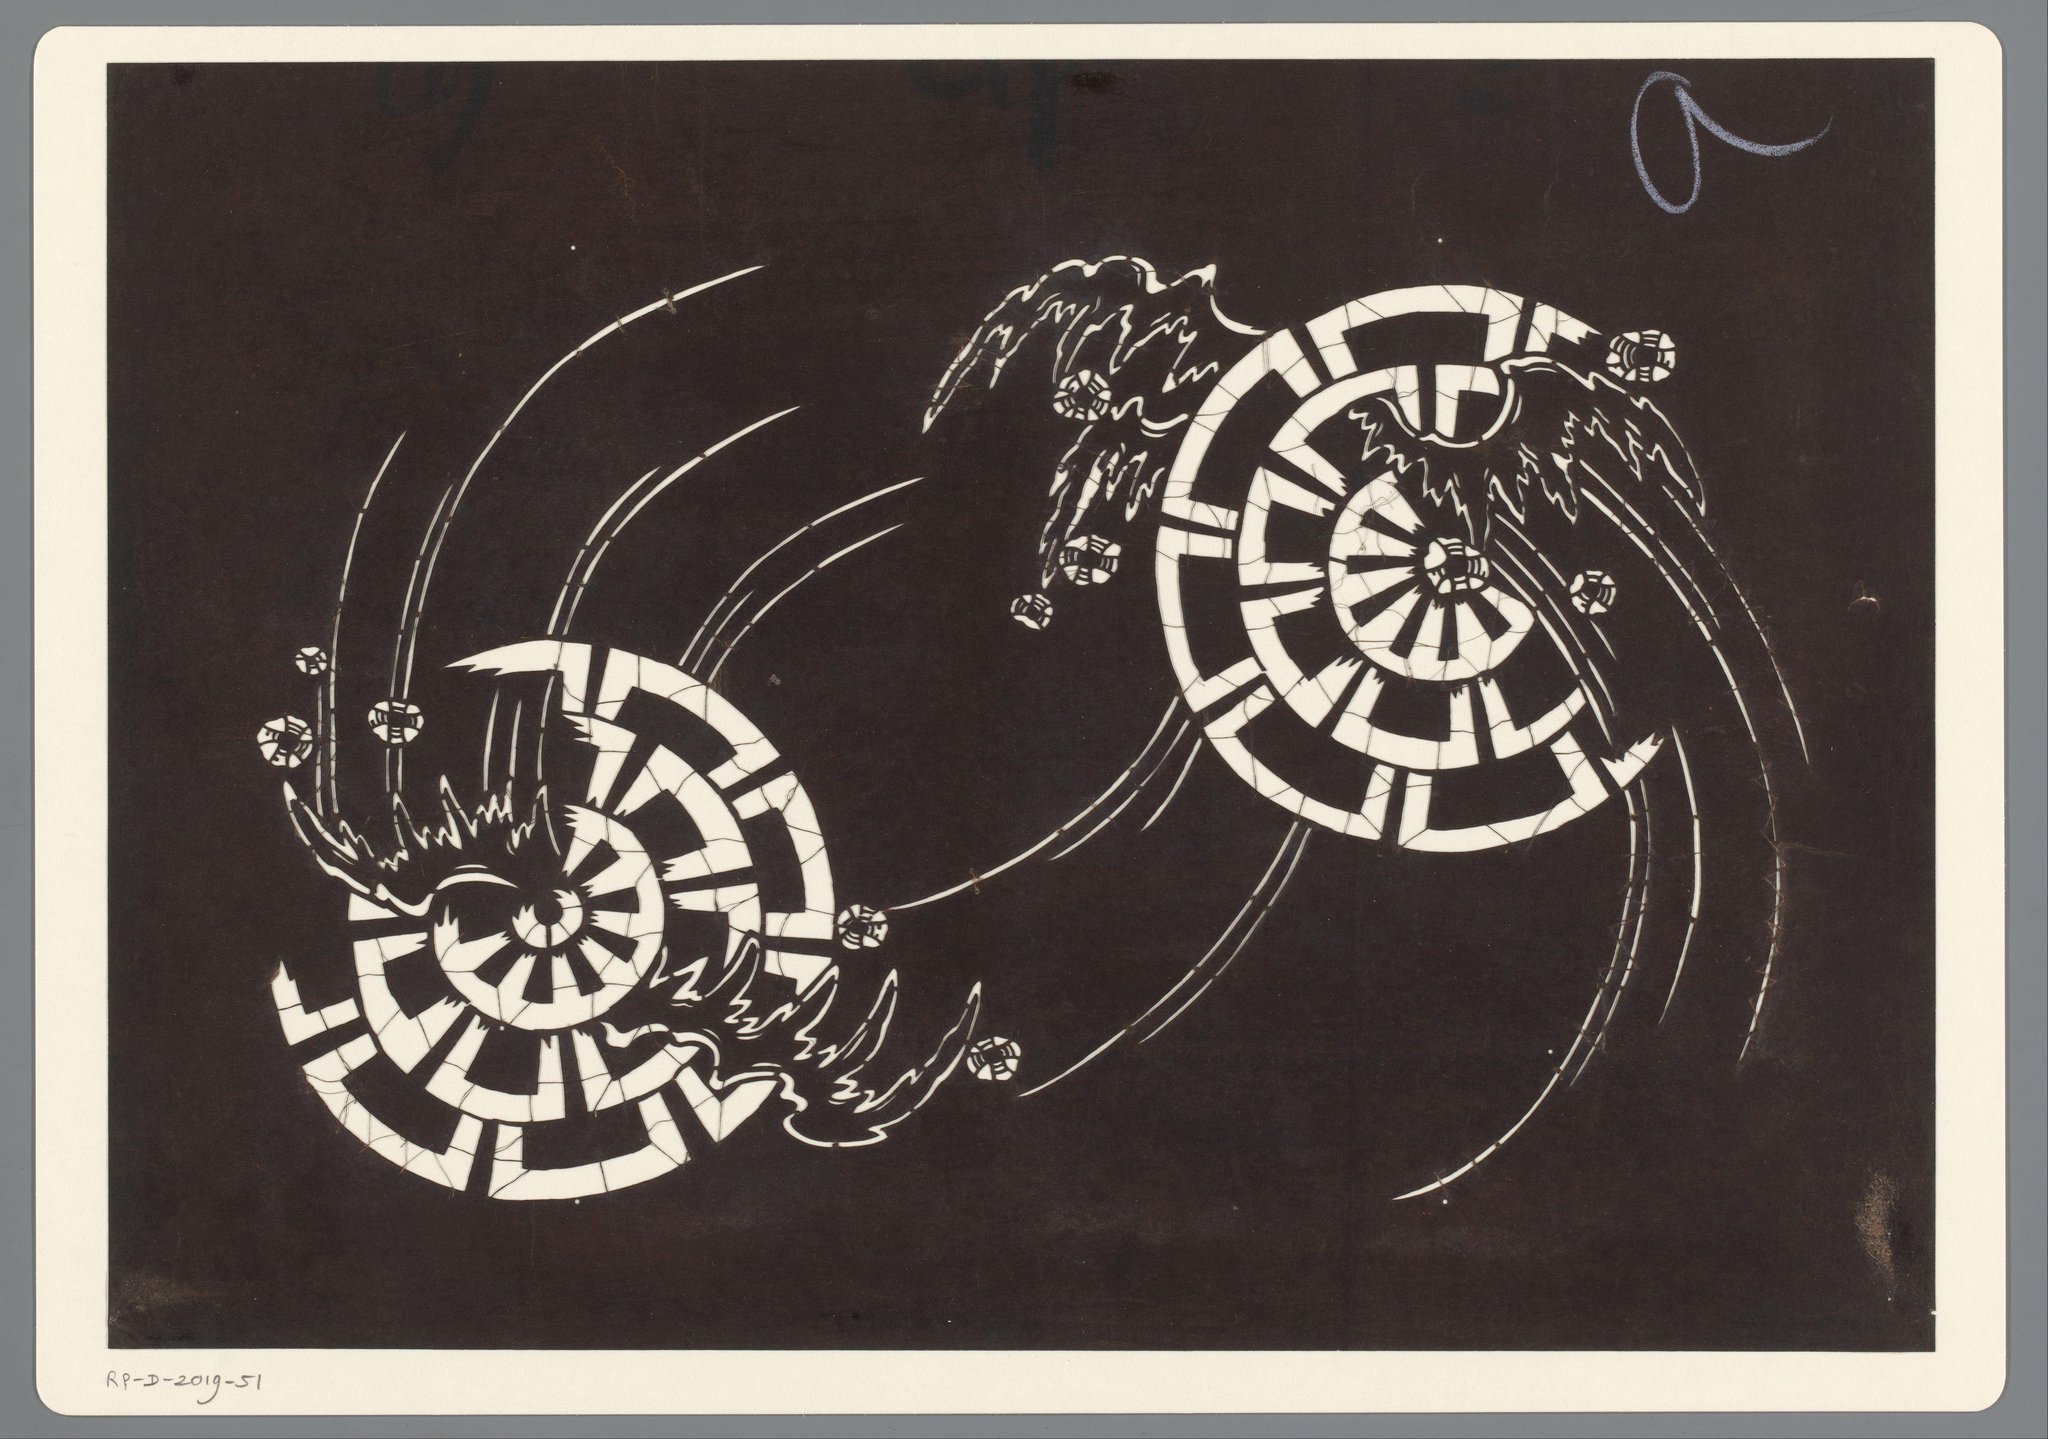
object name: katagami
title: Sjabloon met gebroken wielen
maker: Anonymous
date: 1800-1909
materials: paper, silk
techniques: cutting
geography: japan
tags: ornament ~radiating forms, wheelforms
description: Japanse sjabloon (katagami) met een patroon van twee gebroken wielen gecombineerd met vleugel- of golfmotief.